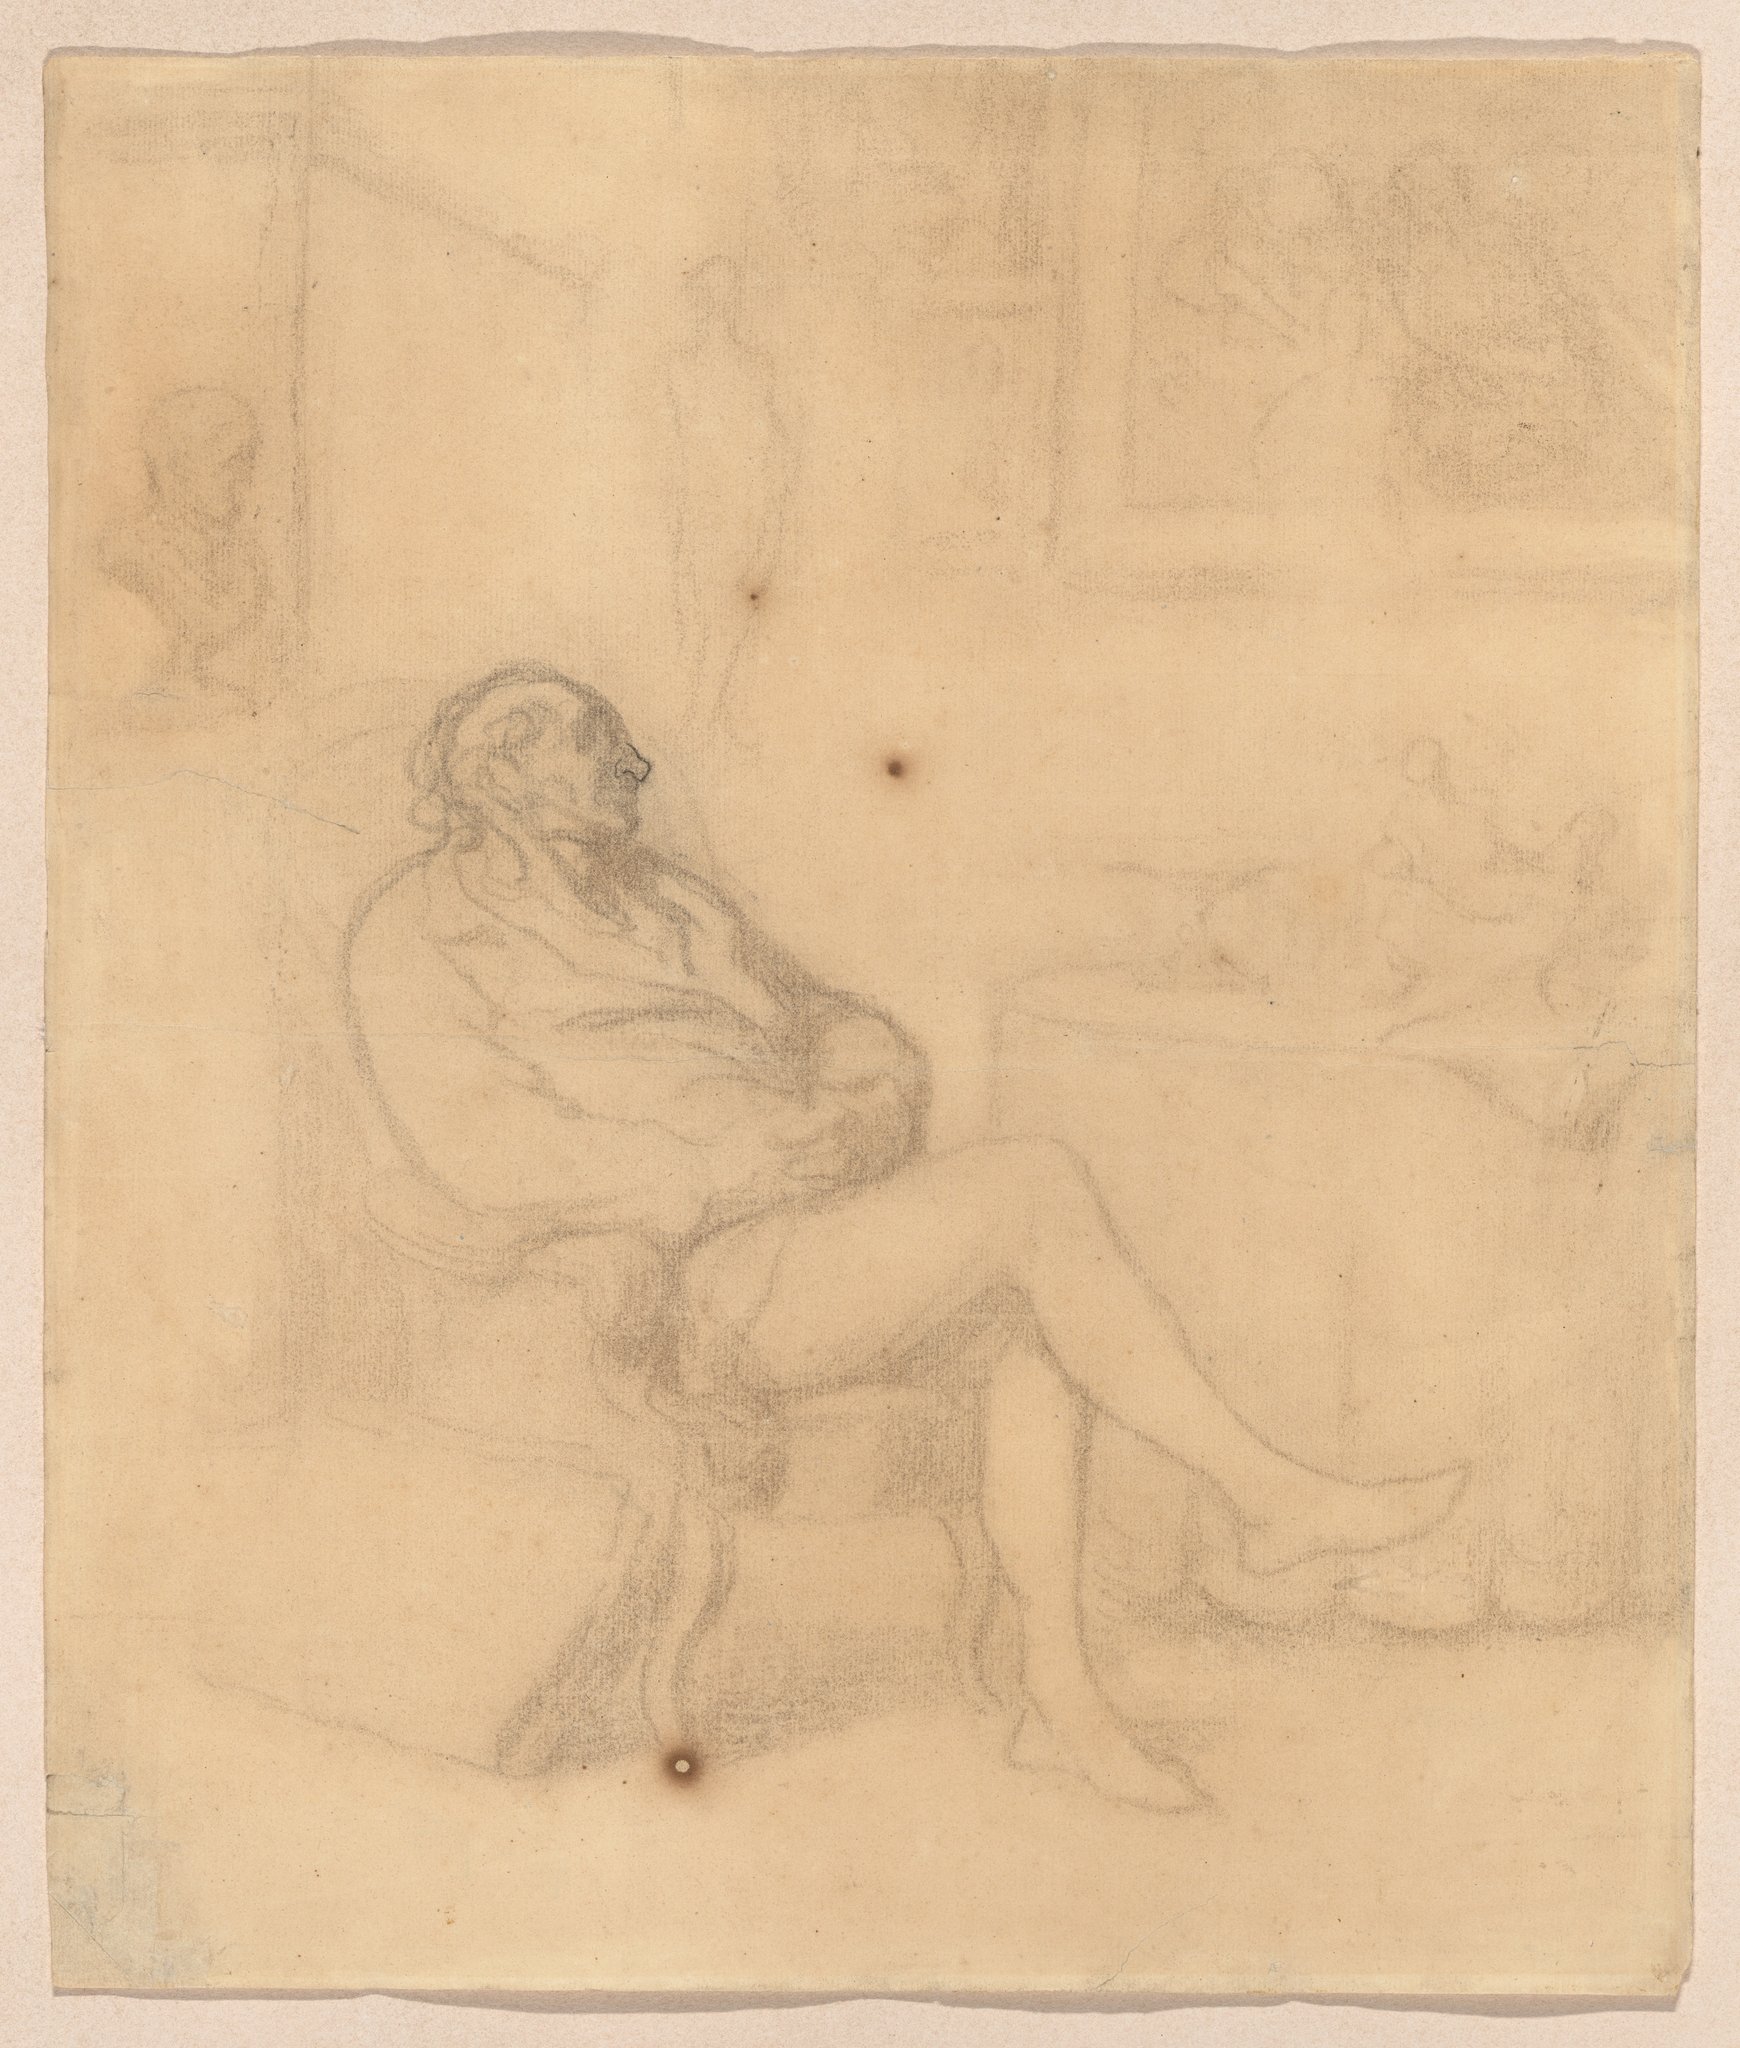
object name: drawing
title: The Connoisseur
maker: honoré daumier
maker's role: artist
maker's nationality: french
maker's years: 1808-1879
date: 1860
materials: crayon, graphite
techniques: printmaking, drawing